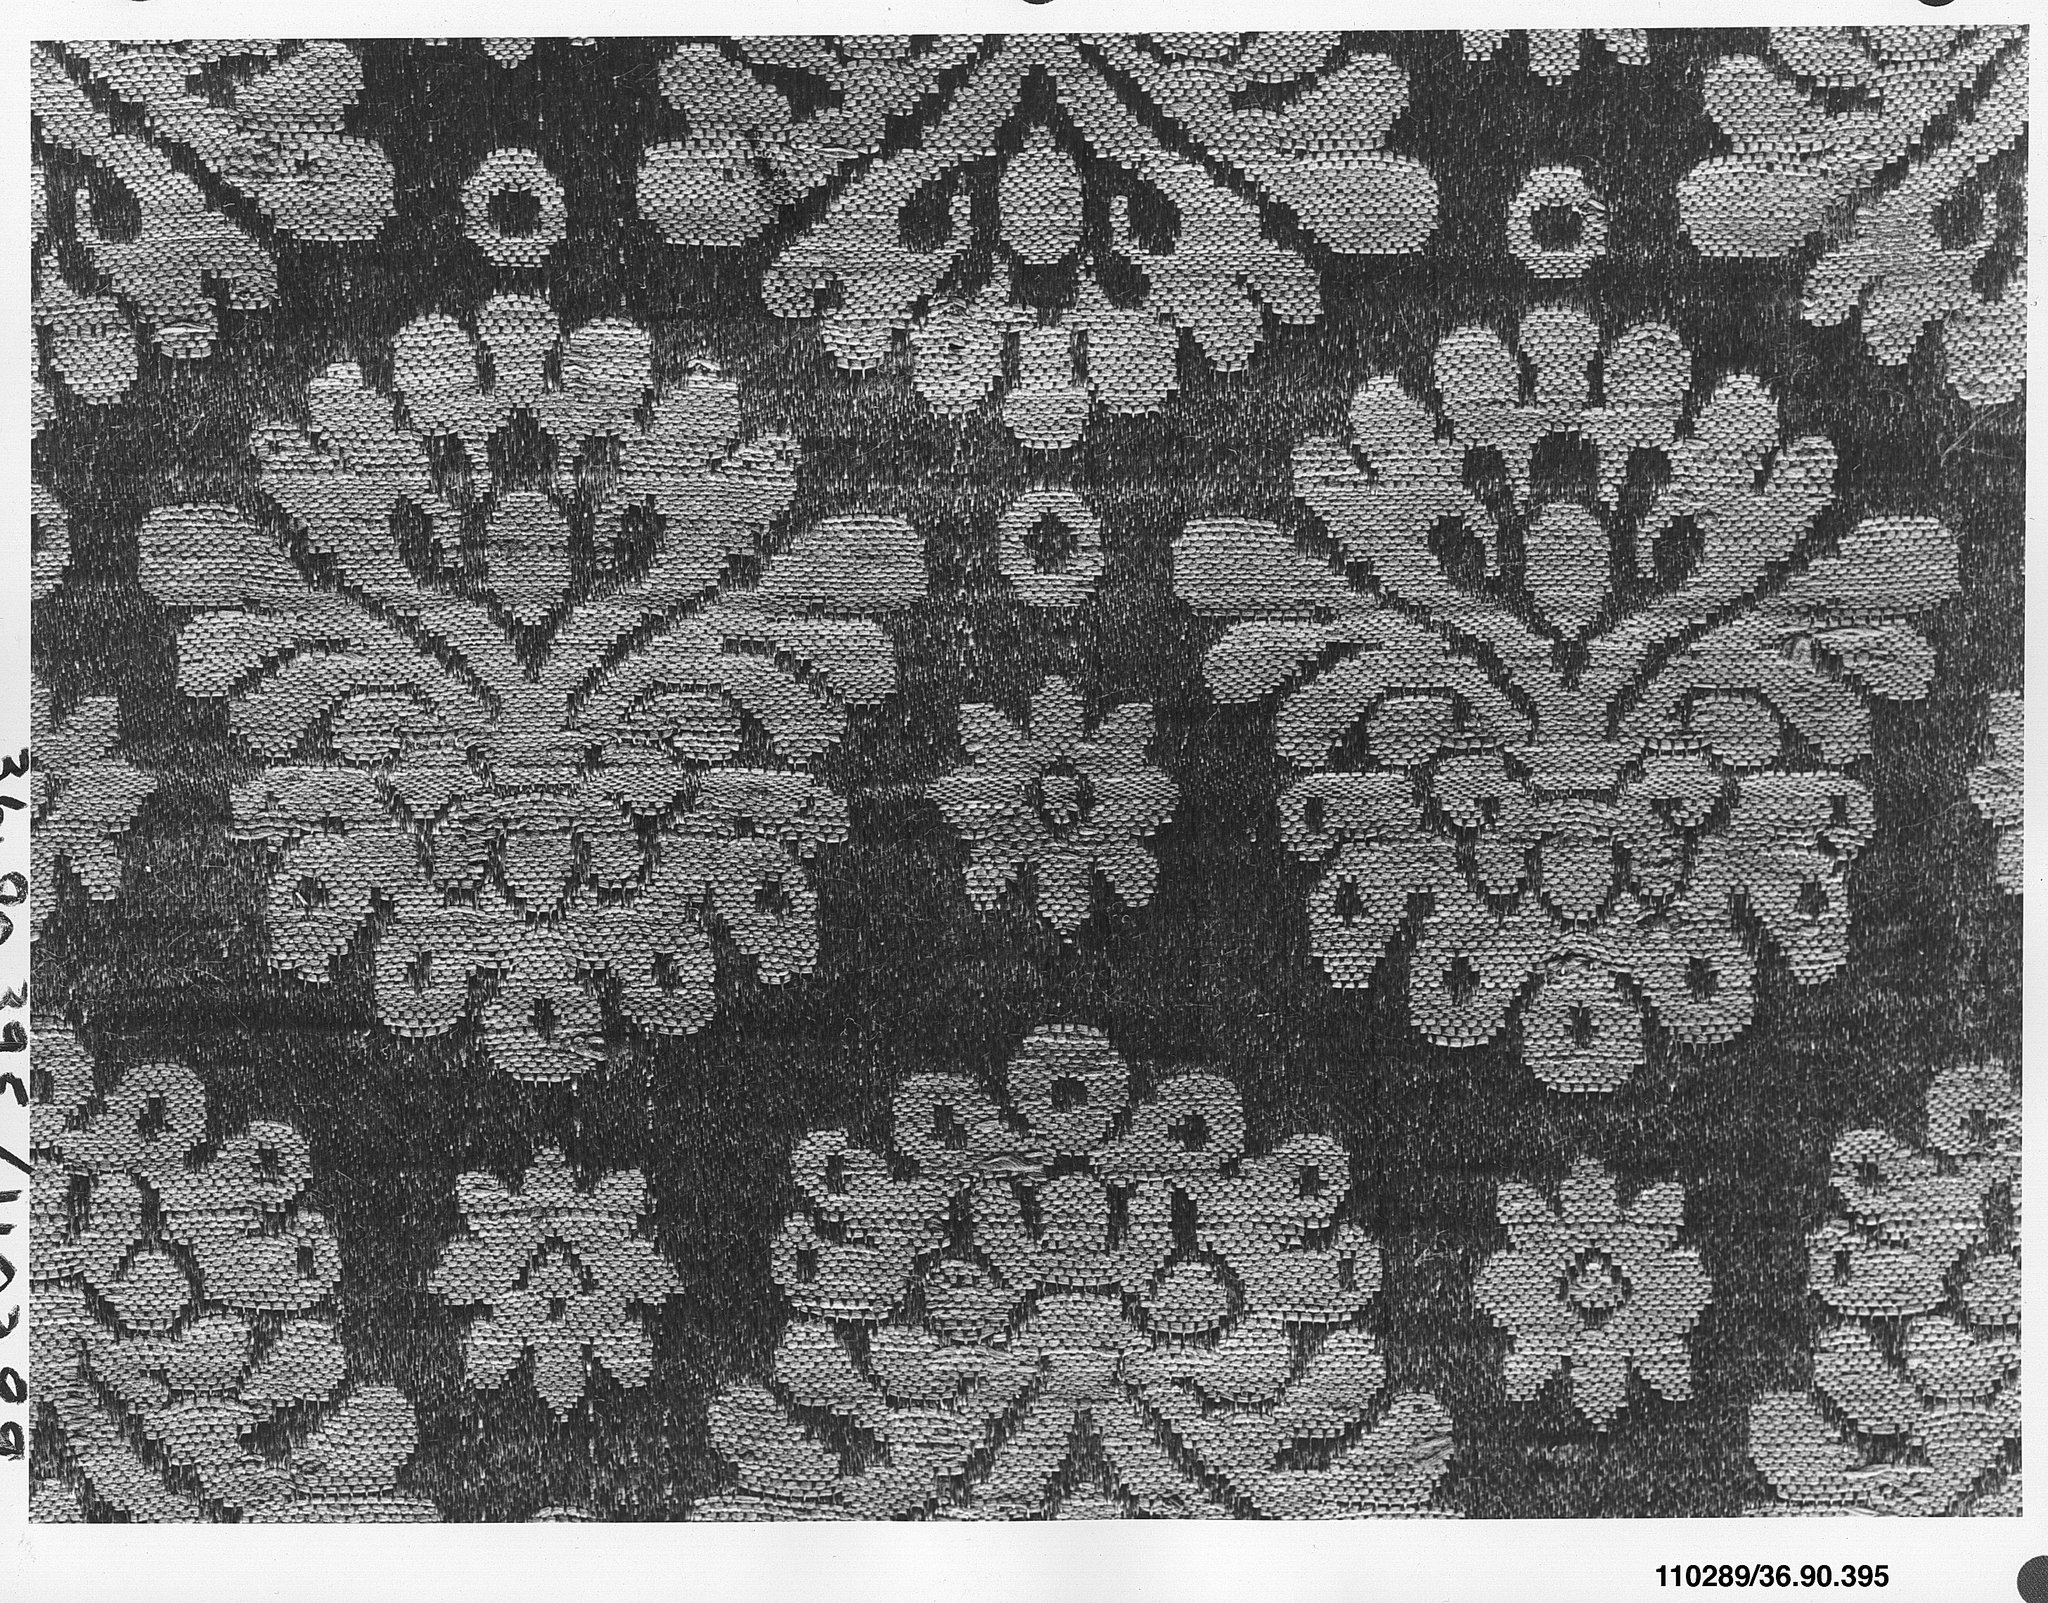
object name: piece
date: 1501-1700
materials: silk